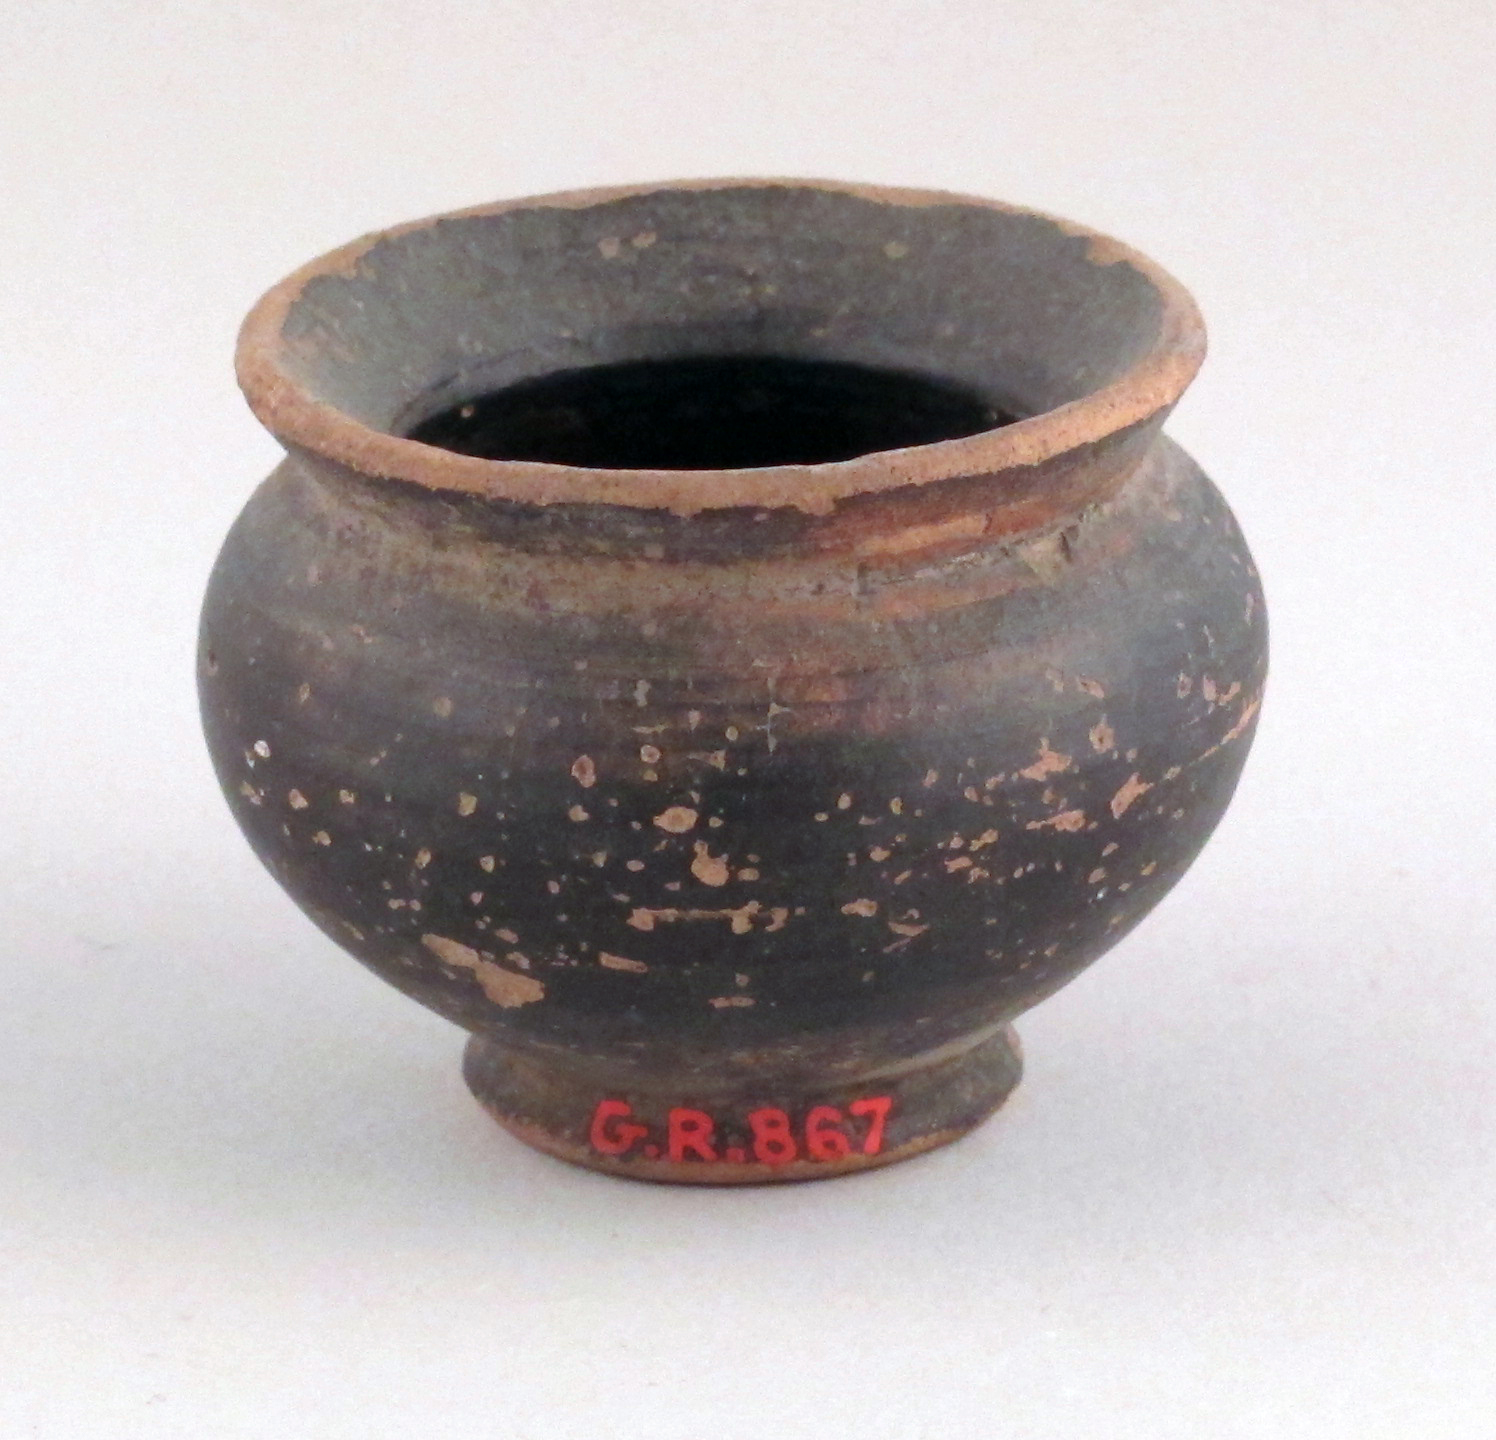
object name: jar, miniature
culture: etruscan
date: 500-301 BCE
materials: terracotta